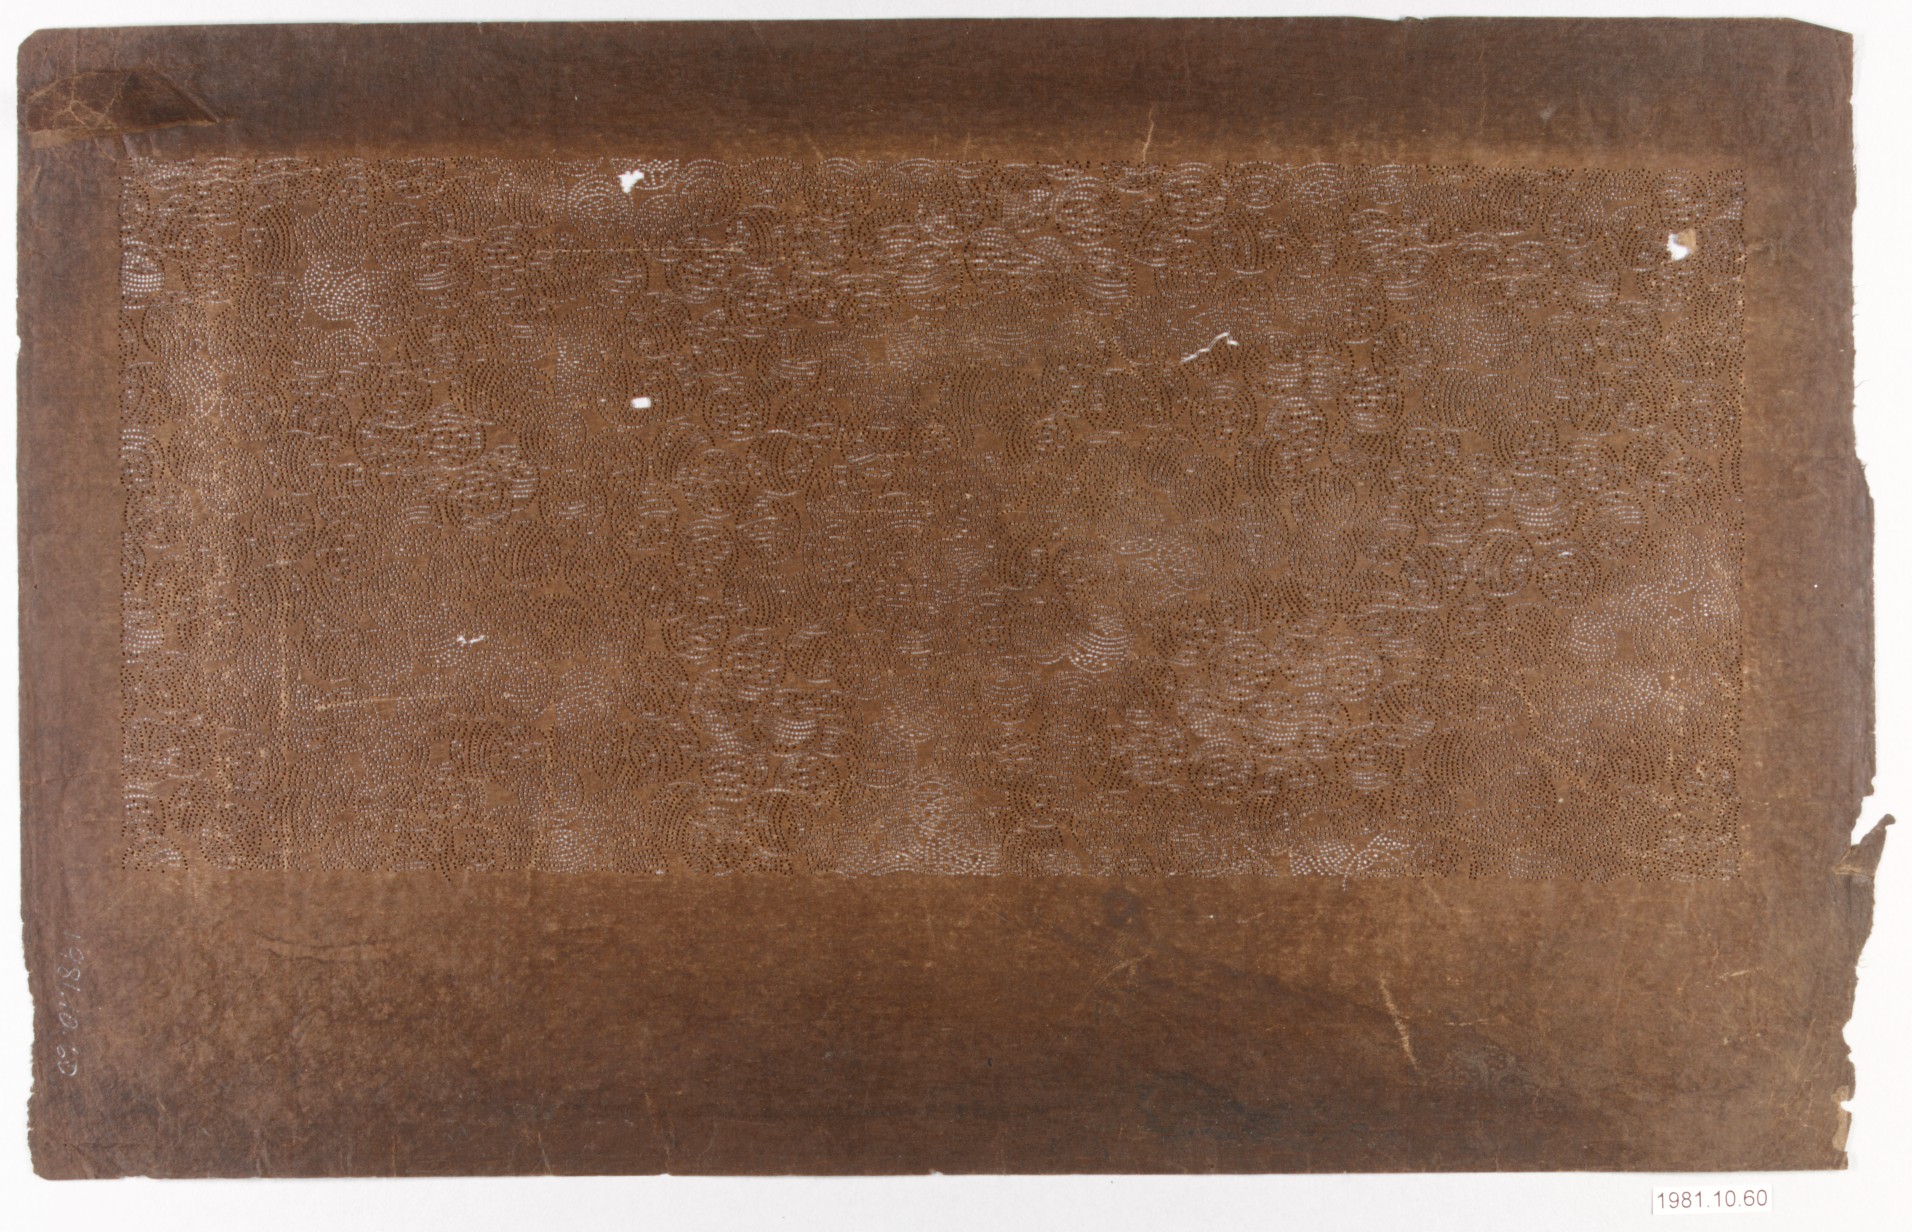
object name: stencil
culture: japanese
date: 1801-1900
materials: paper